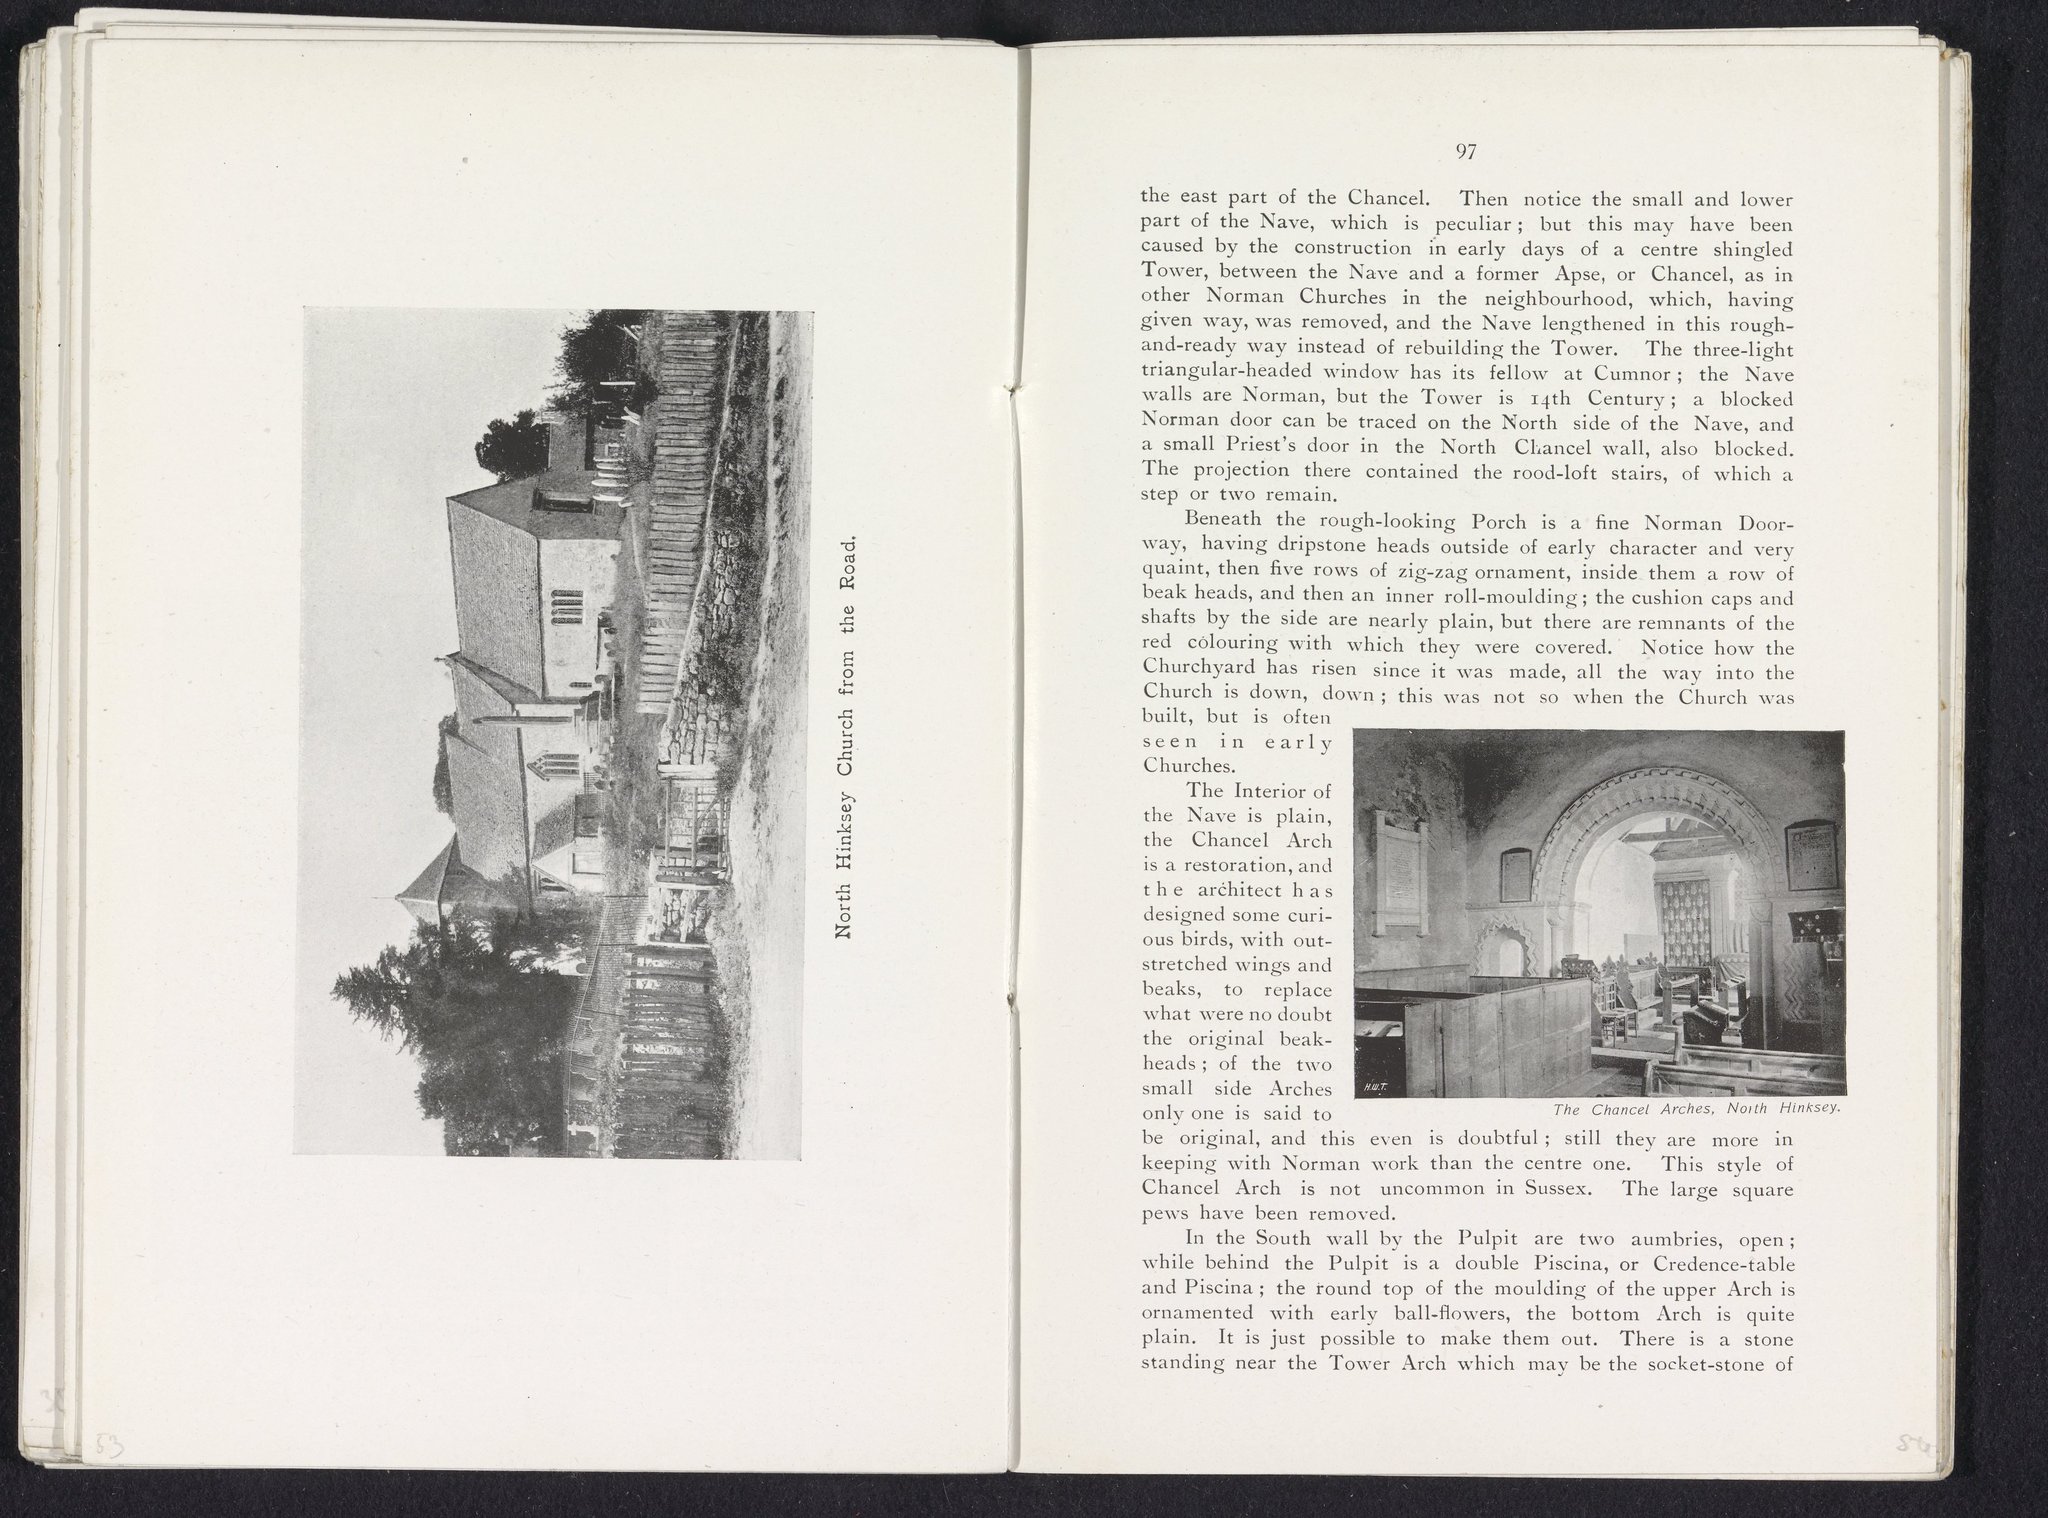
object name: photomechanical print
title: The chancel arches, North Hinksey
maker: henry w. taunt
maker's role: fotograaf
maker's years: 1842-1922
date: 1907-1912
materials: paper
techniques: autotype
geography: saint lawrence's church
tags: interior of church